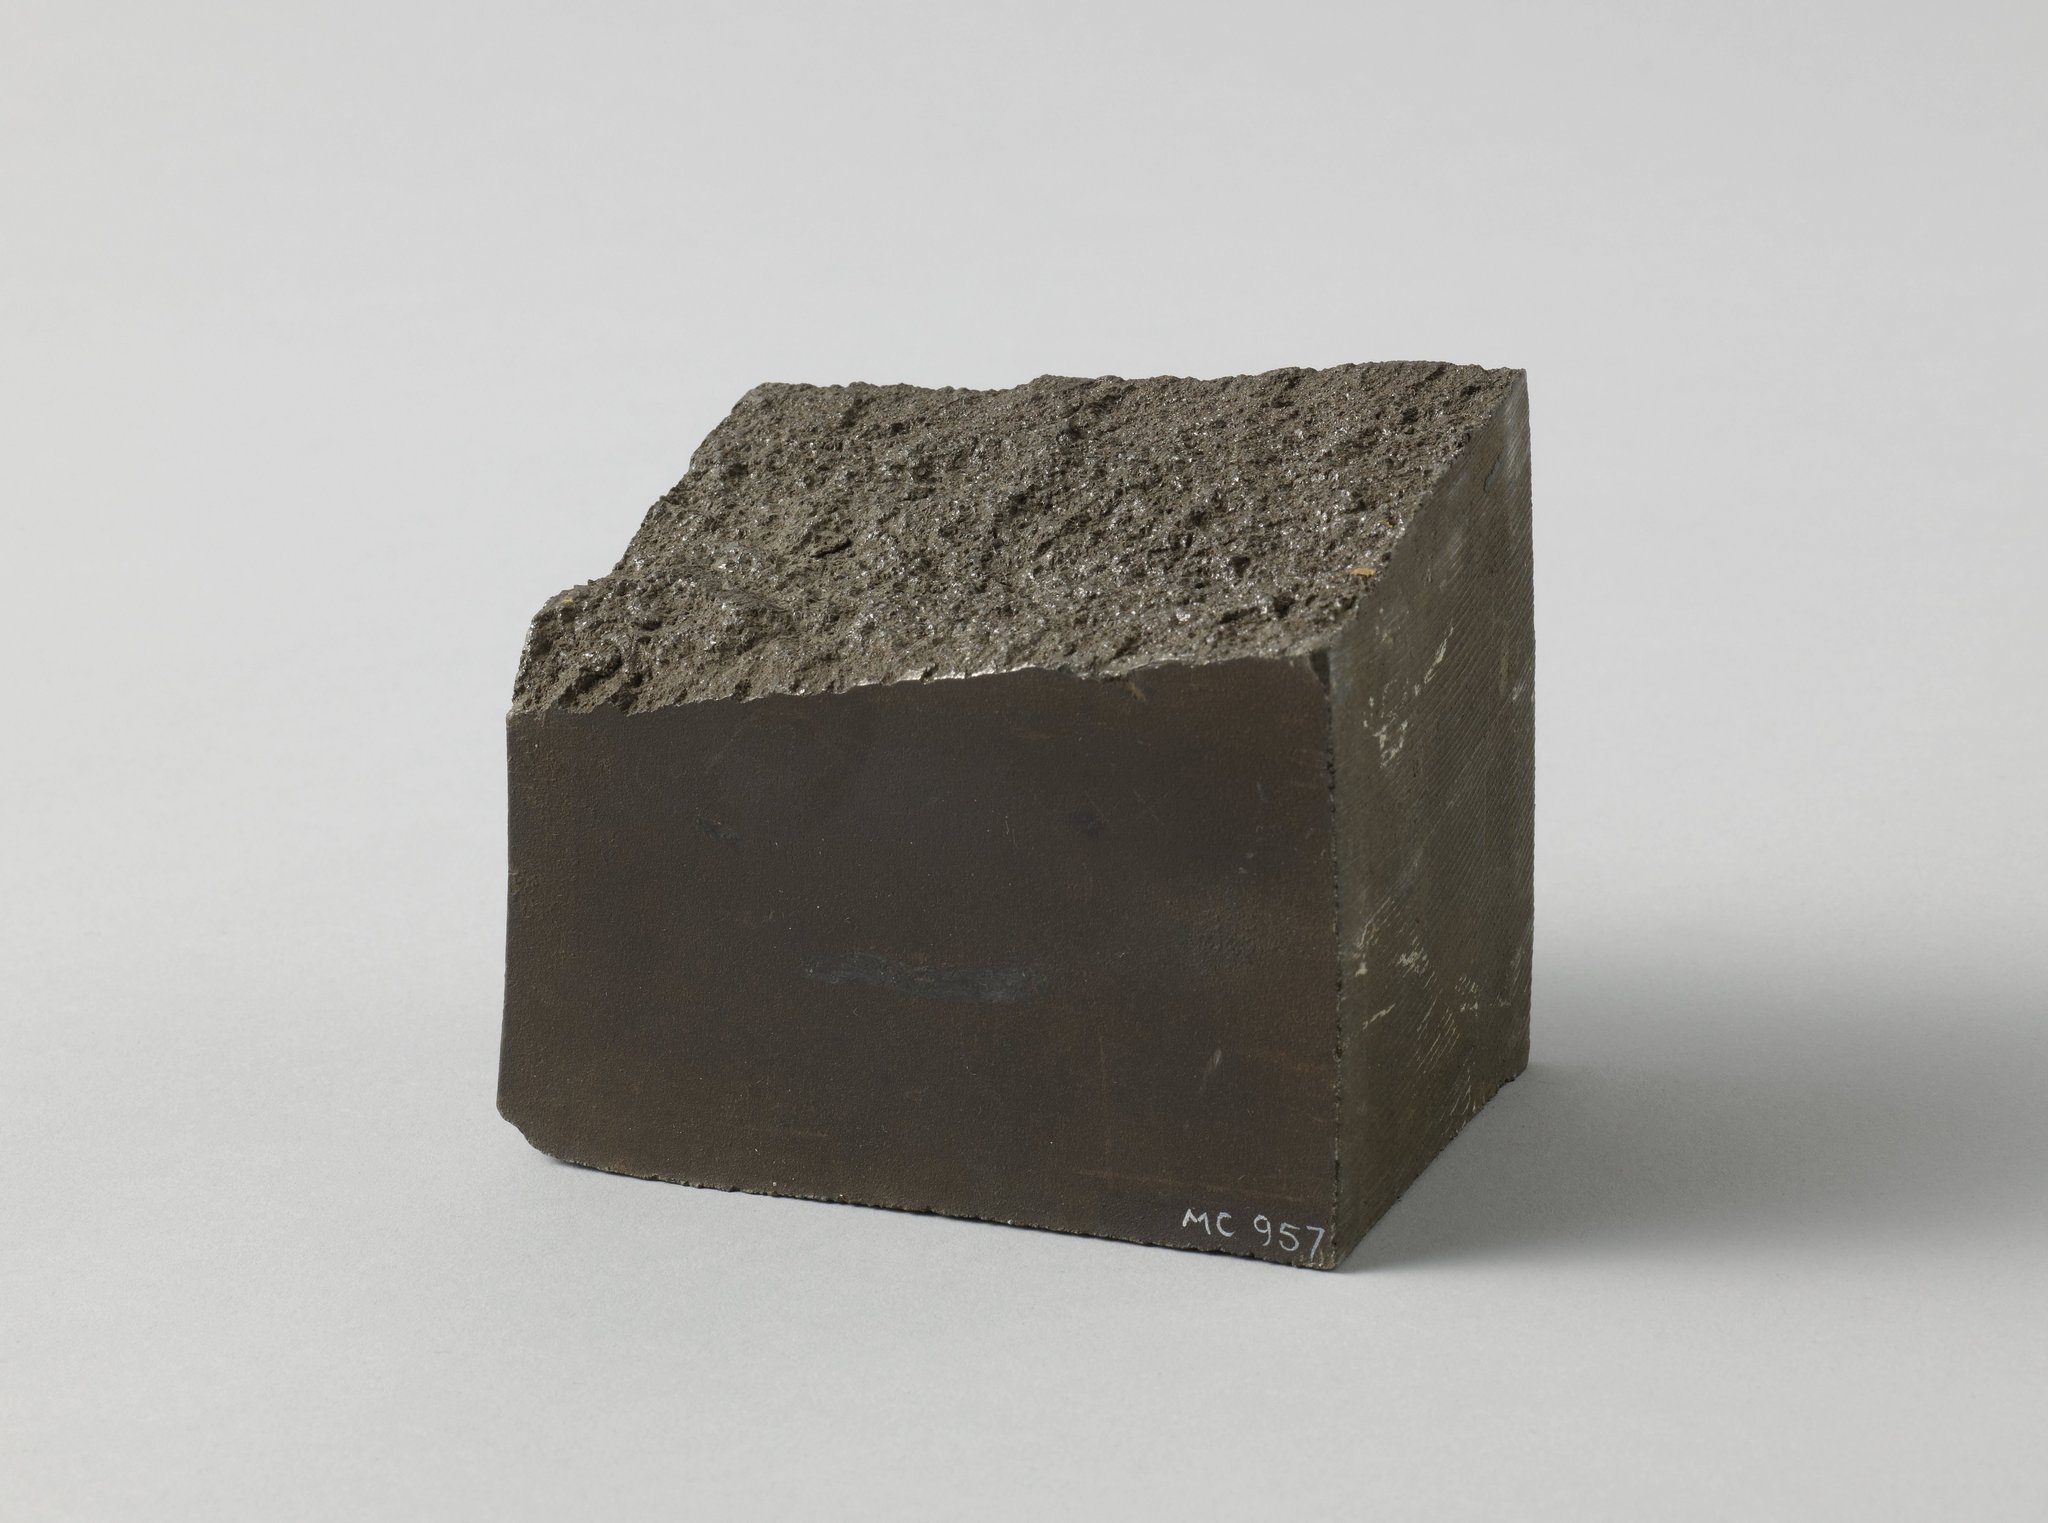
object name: sample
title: Cast Iron Sample, Taken from a Gun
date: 1859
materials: iron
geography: essen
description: NG-MC-957 was een monster van gietijzer dat De Fremery in februari 1859 aan de Modellenkamer aanbood. Het kwam van de mantel van een kanon van 60 pond, dat door Krupp voor de Nederlandse Marine was gegoten, maar wegens een kleine fout bij de tappen werd afgekeurd.